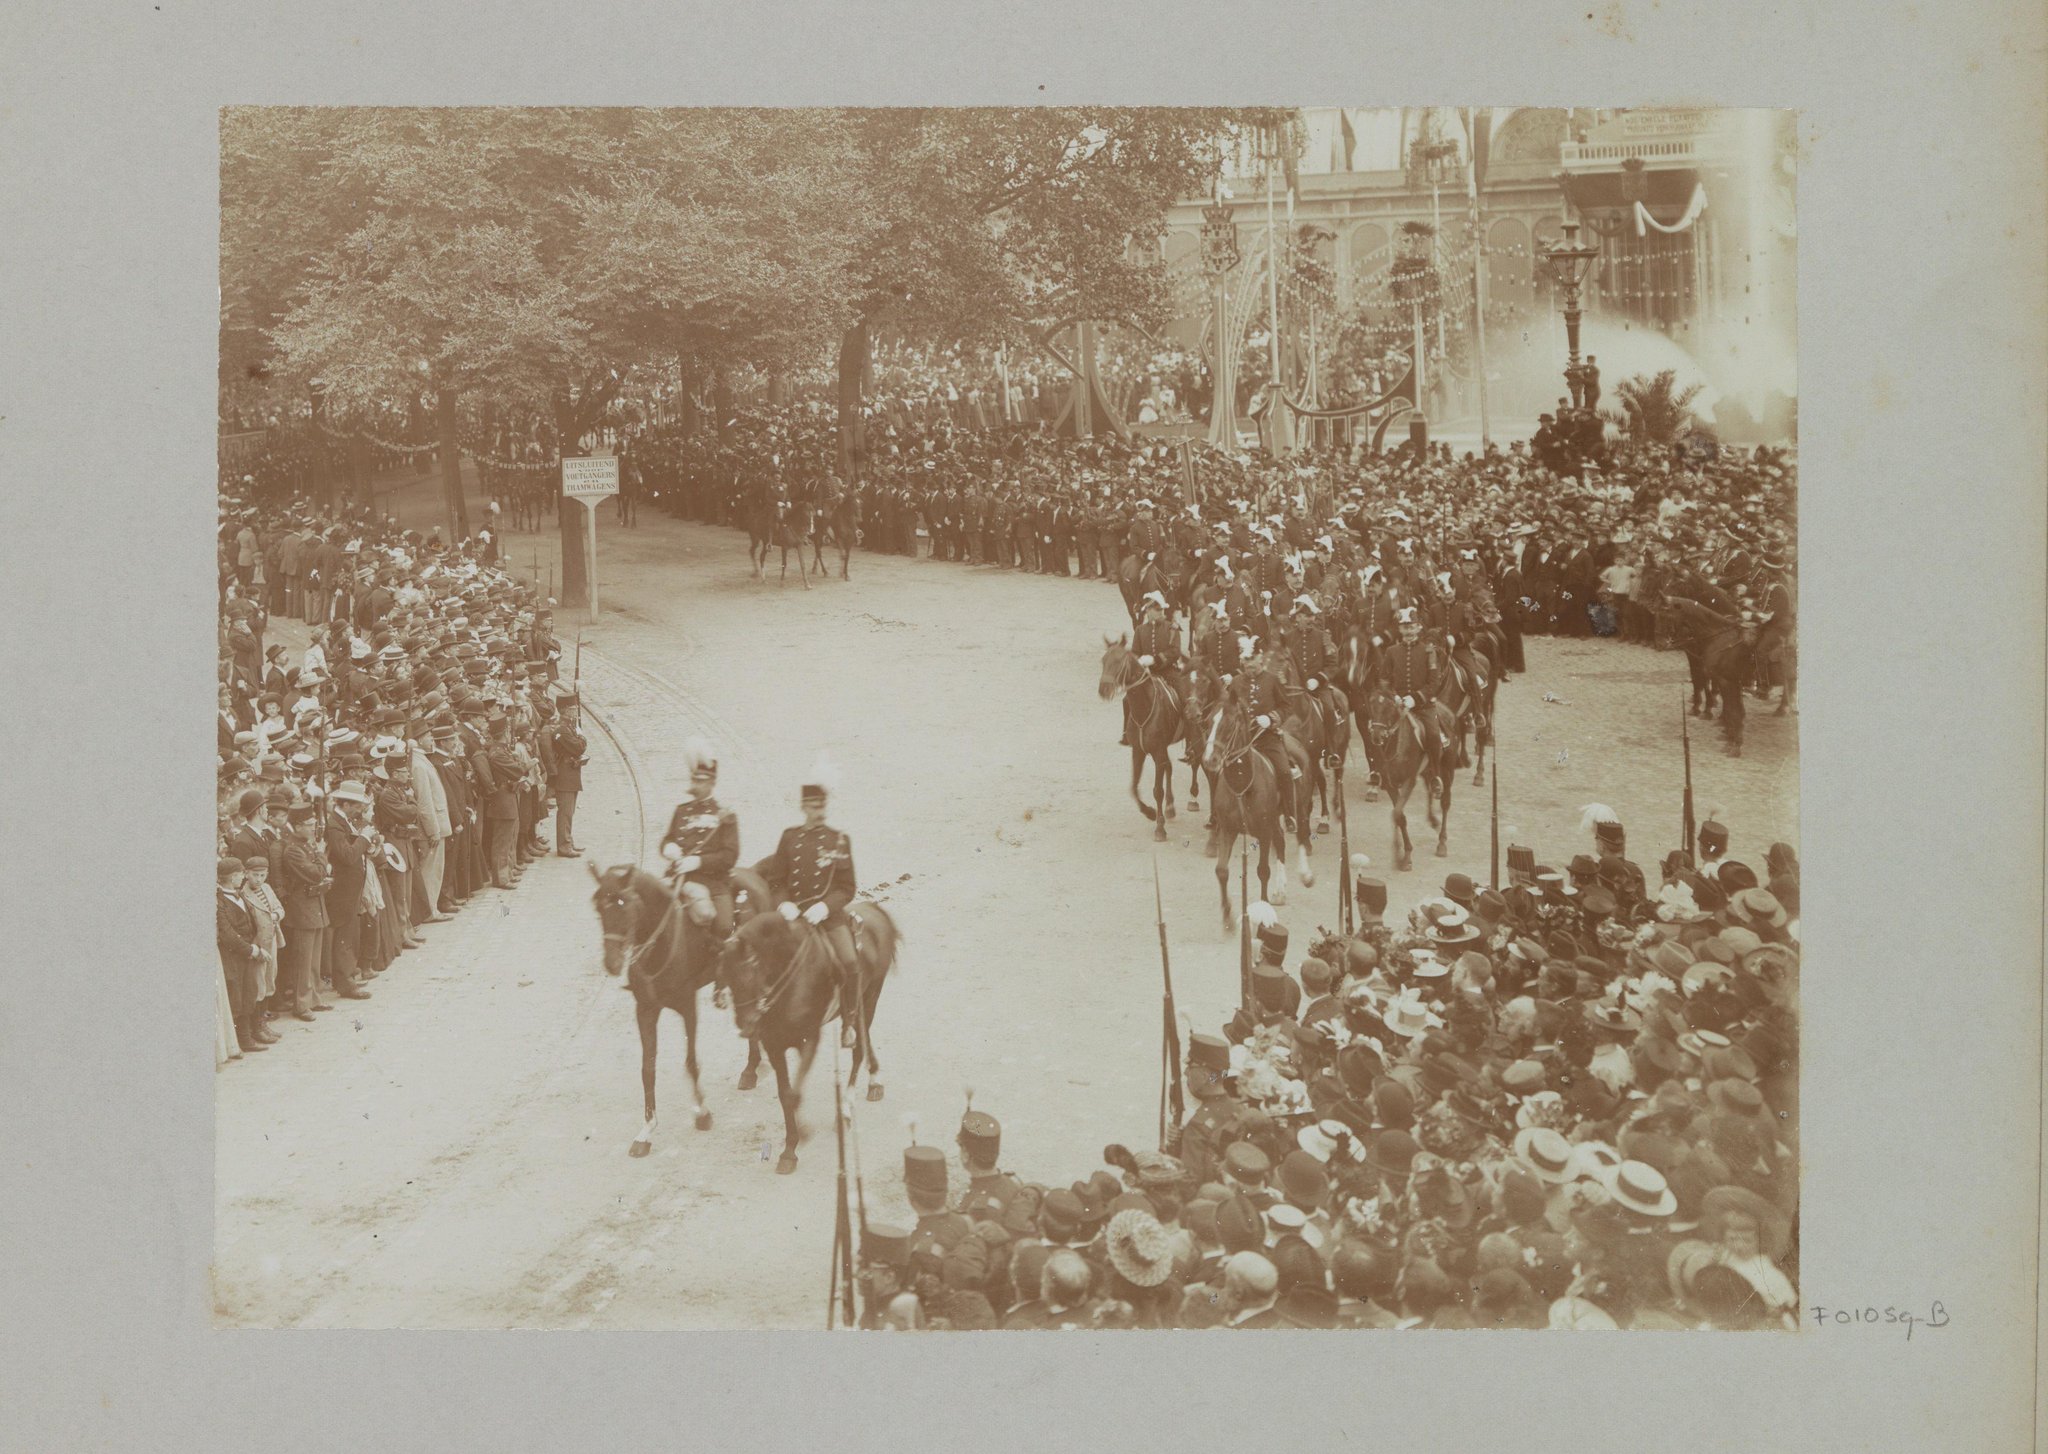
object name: photograph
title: Ruiterescorte op het Frederiksplein te Amsterdam tijdens de intocht van koningin Wilhelmina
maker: barend groote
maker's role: fotograaf, fotohandel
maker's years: 1862-1946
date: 1809-1898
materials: photographic support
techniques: collodion silver print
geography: frederiksplein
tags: riding a horse, ass, or mule; rider, horseman, ceremonial celebration of installation of a ruler, crowd, mob, public festivities on the occasion of royal events, installation of a ruler - bb - female ruler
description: Onderdeel van Fotoalbum met vijftien opnames van de inhuldiging van koningin Wilhelmina en de inhuldigingsfeesten.